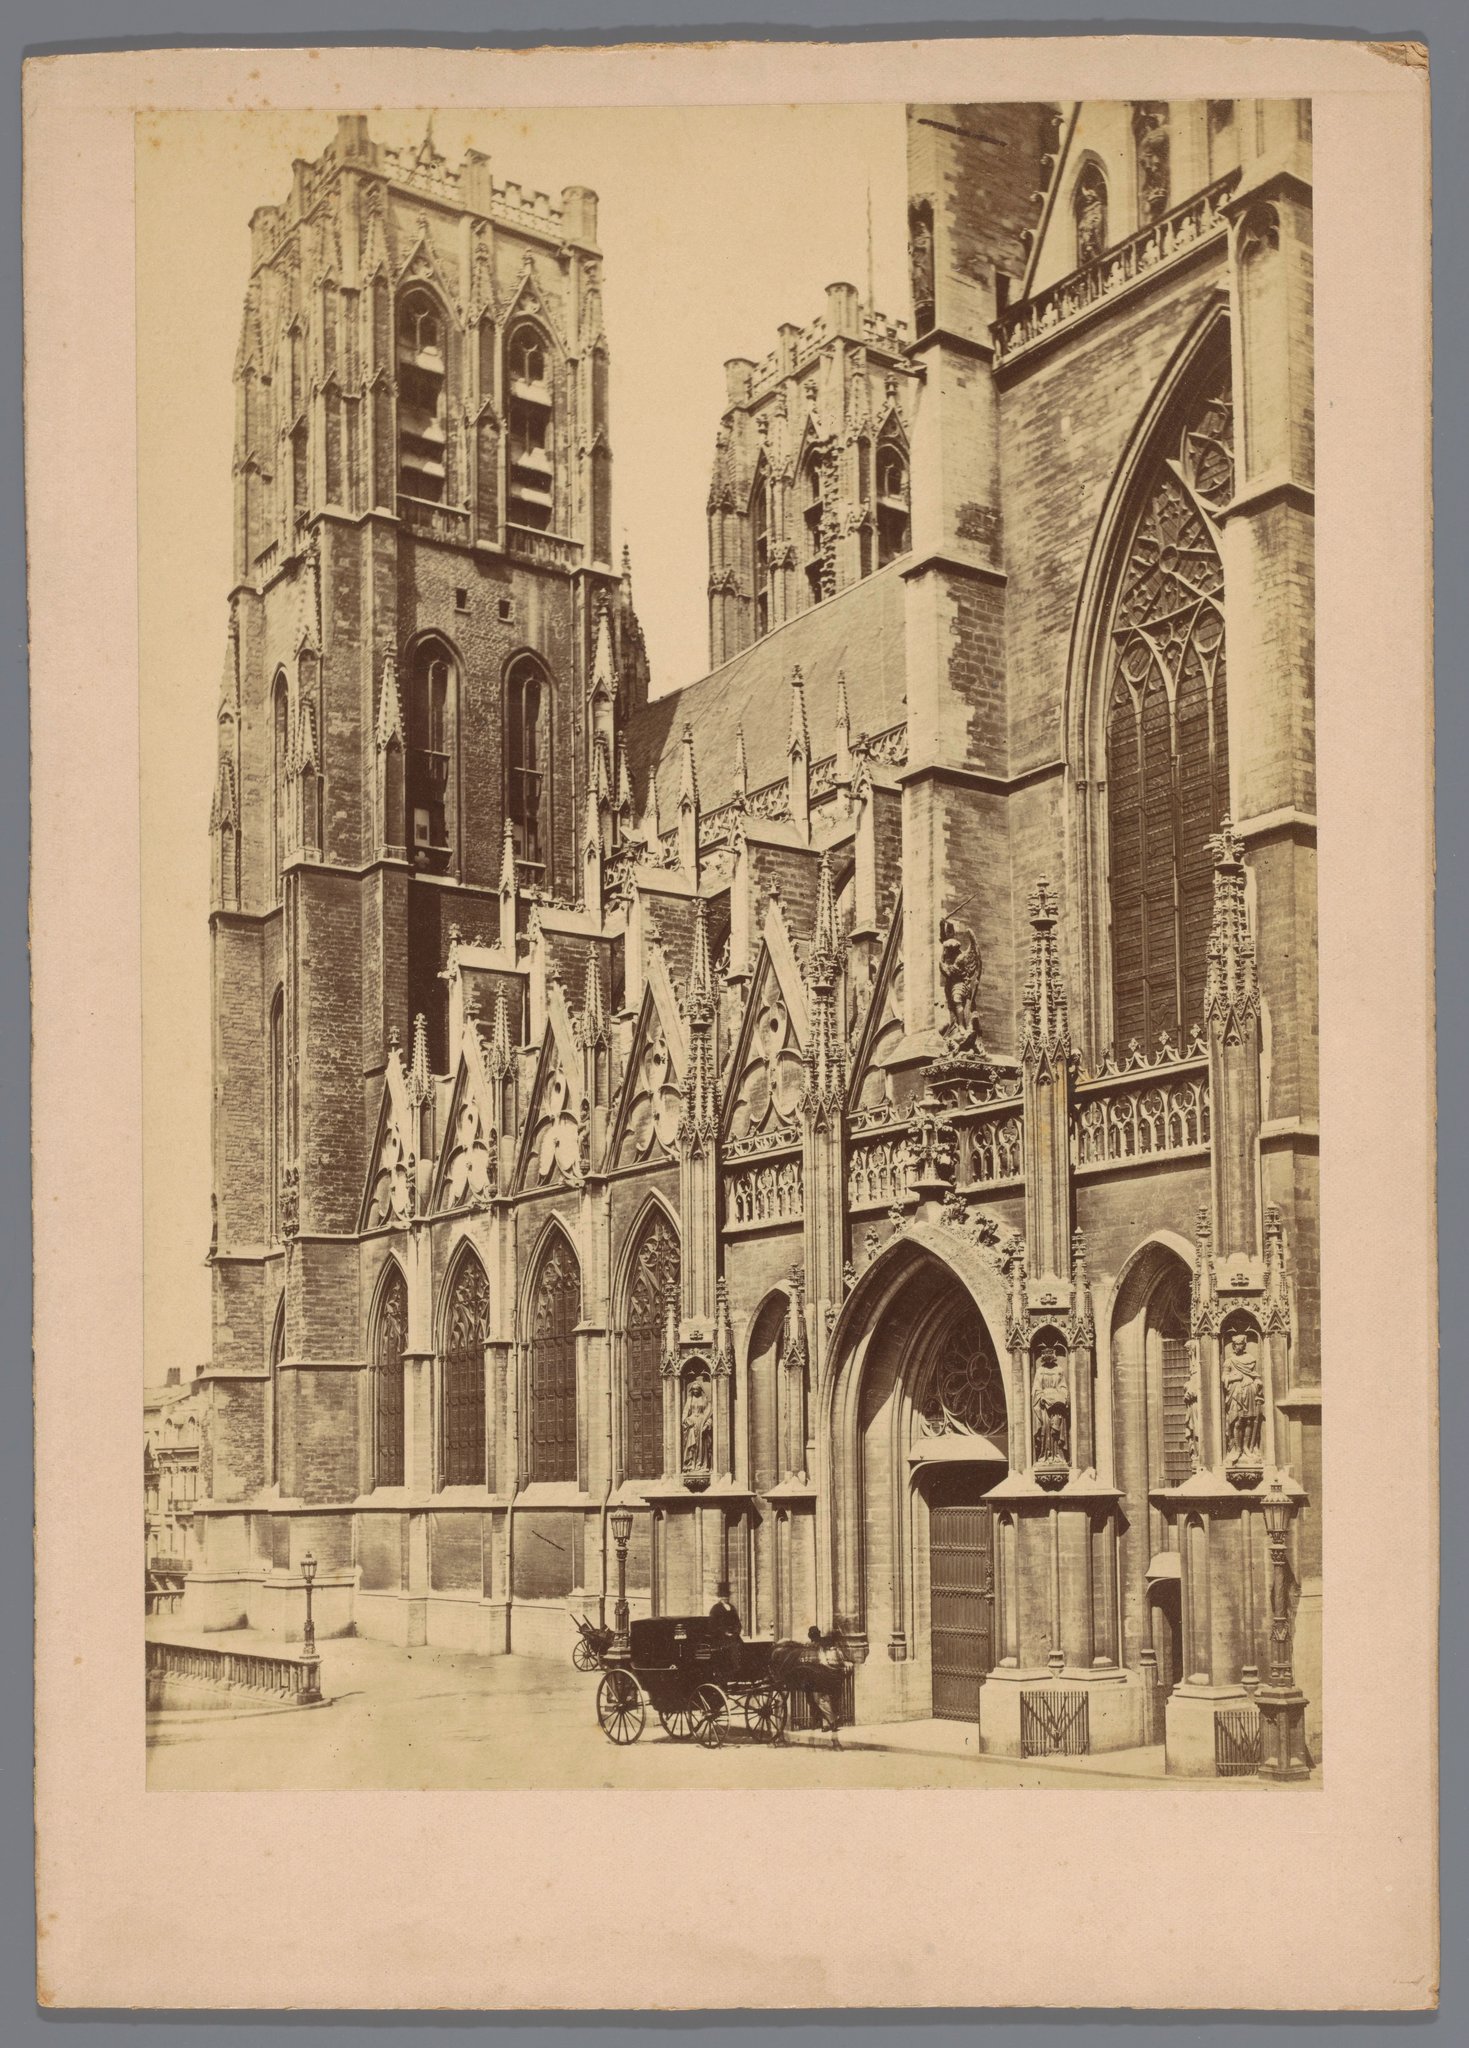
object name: photograph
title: Exterieur van de Sint-Michiel-en-Sint-Goedelekathedraal in Brussel, België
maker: Anonymous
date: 1860-1890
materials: cardboard, paper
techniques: albumen print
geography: brussels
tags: four-wheeled vehicle drawn by one animal, church (exterior)